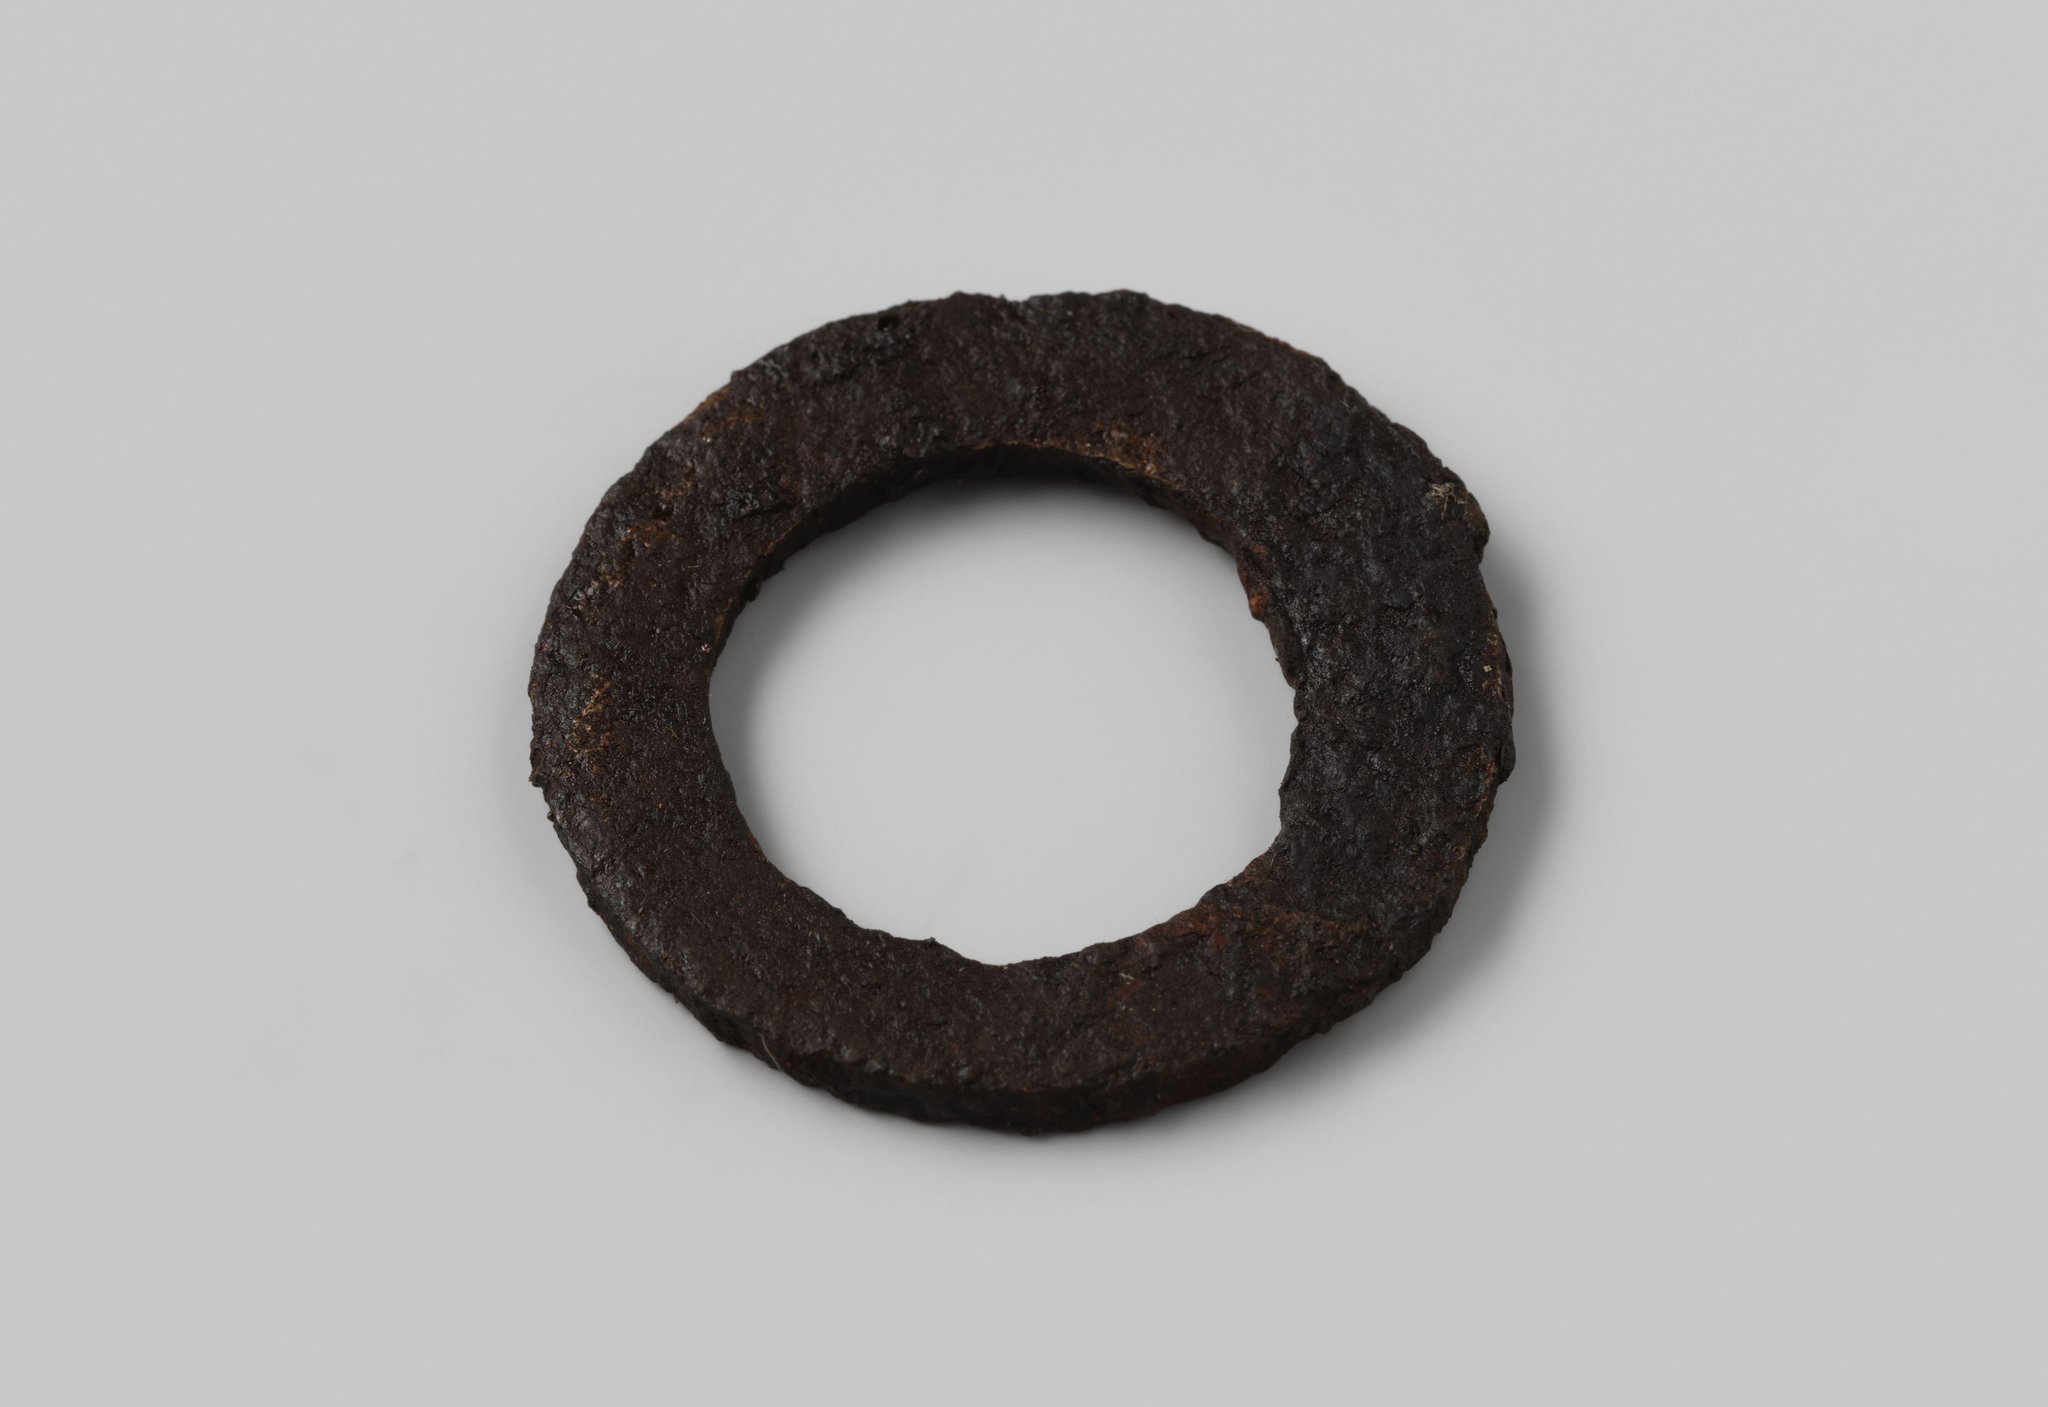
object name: ring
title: Ringvormig fragment uit het wrak van de Oost-Indiëvaarder Hollandia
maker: Anonymous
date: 1700-1743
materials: iron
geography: netherlands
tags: verenigde oostindische compagnie, hollandia (schip), annet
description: Varied parts or fragments, rings and ring-shaped fragments; circular, flat.